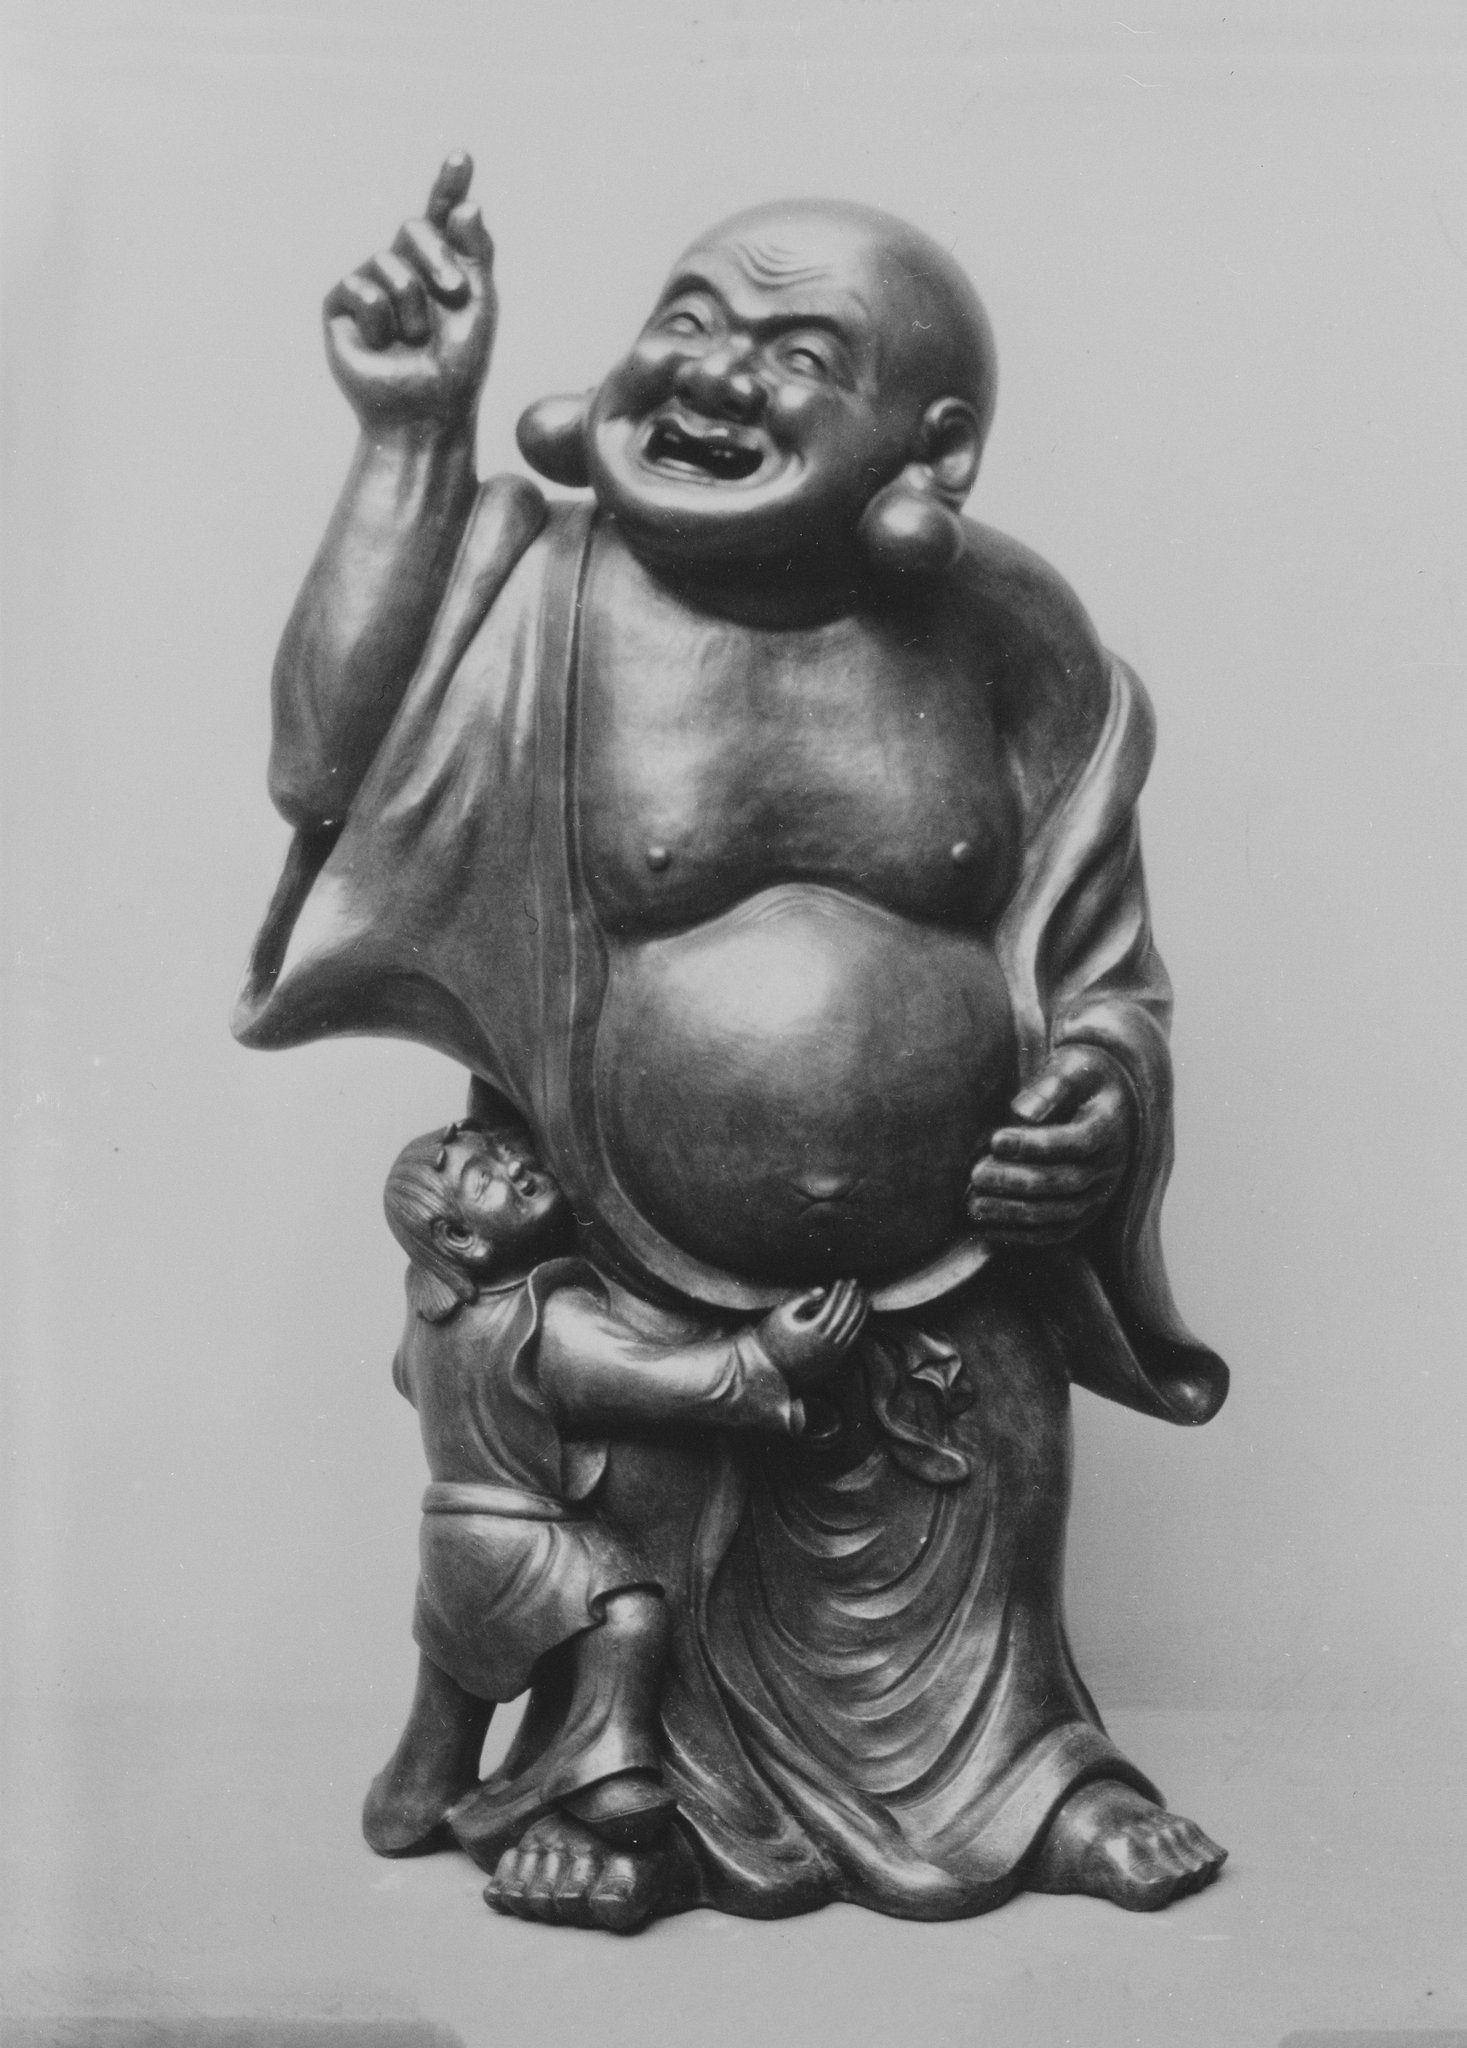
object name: group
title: Hotei and Child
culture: japanese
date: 1820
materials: glaze, stoneware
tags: boys,men